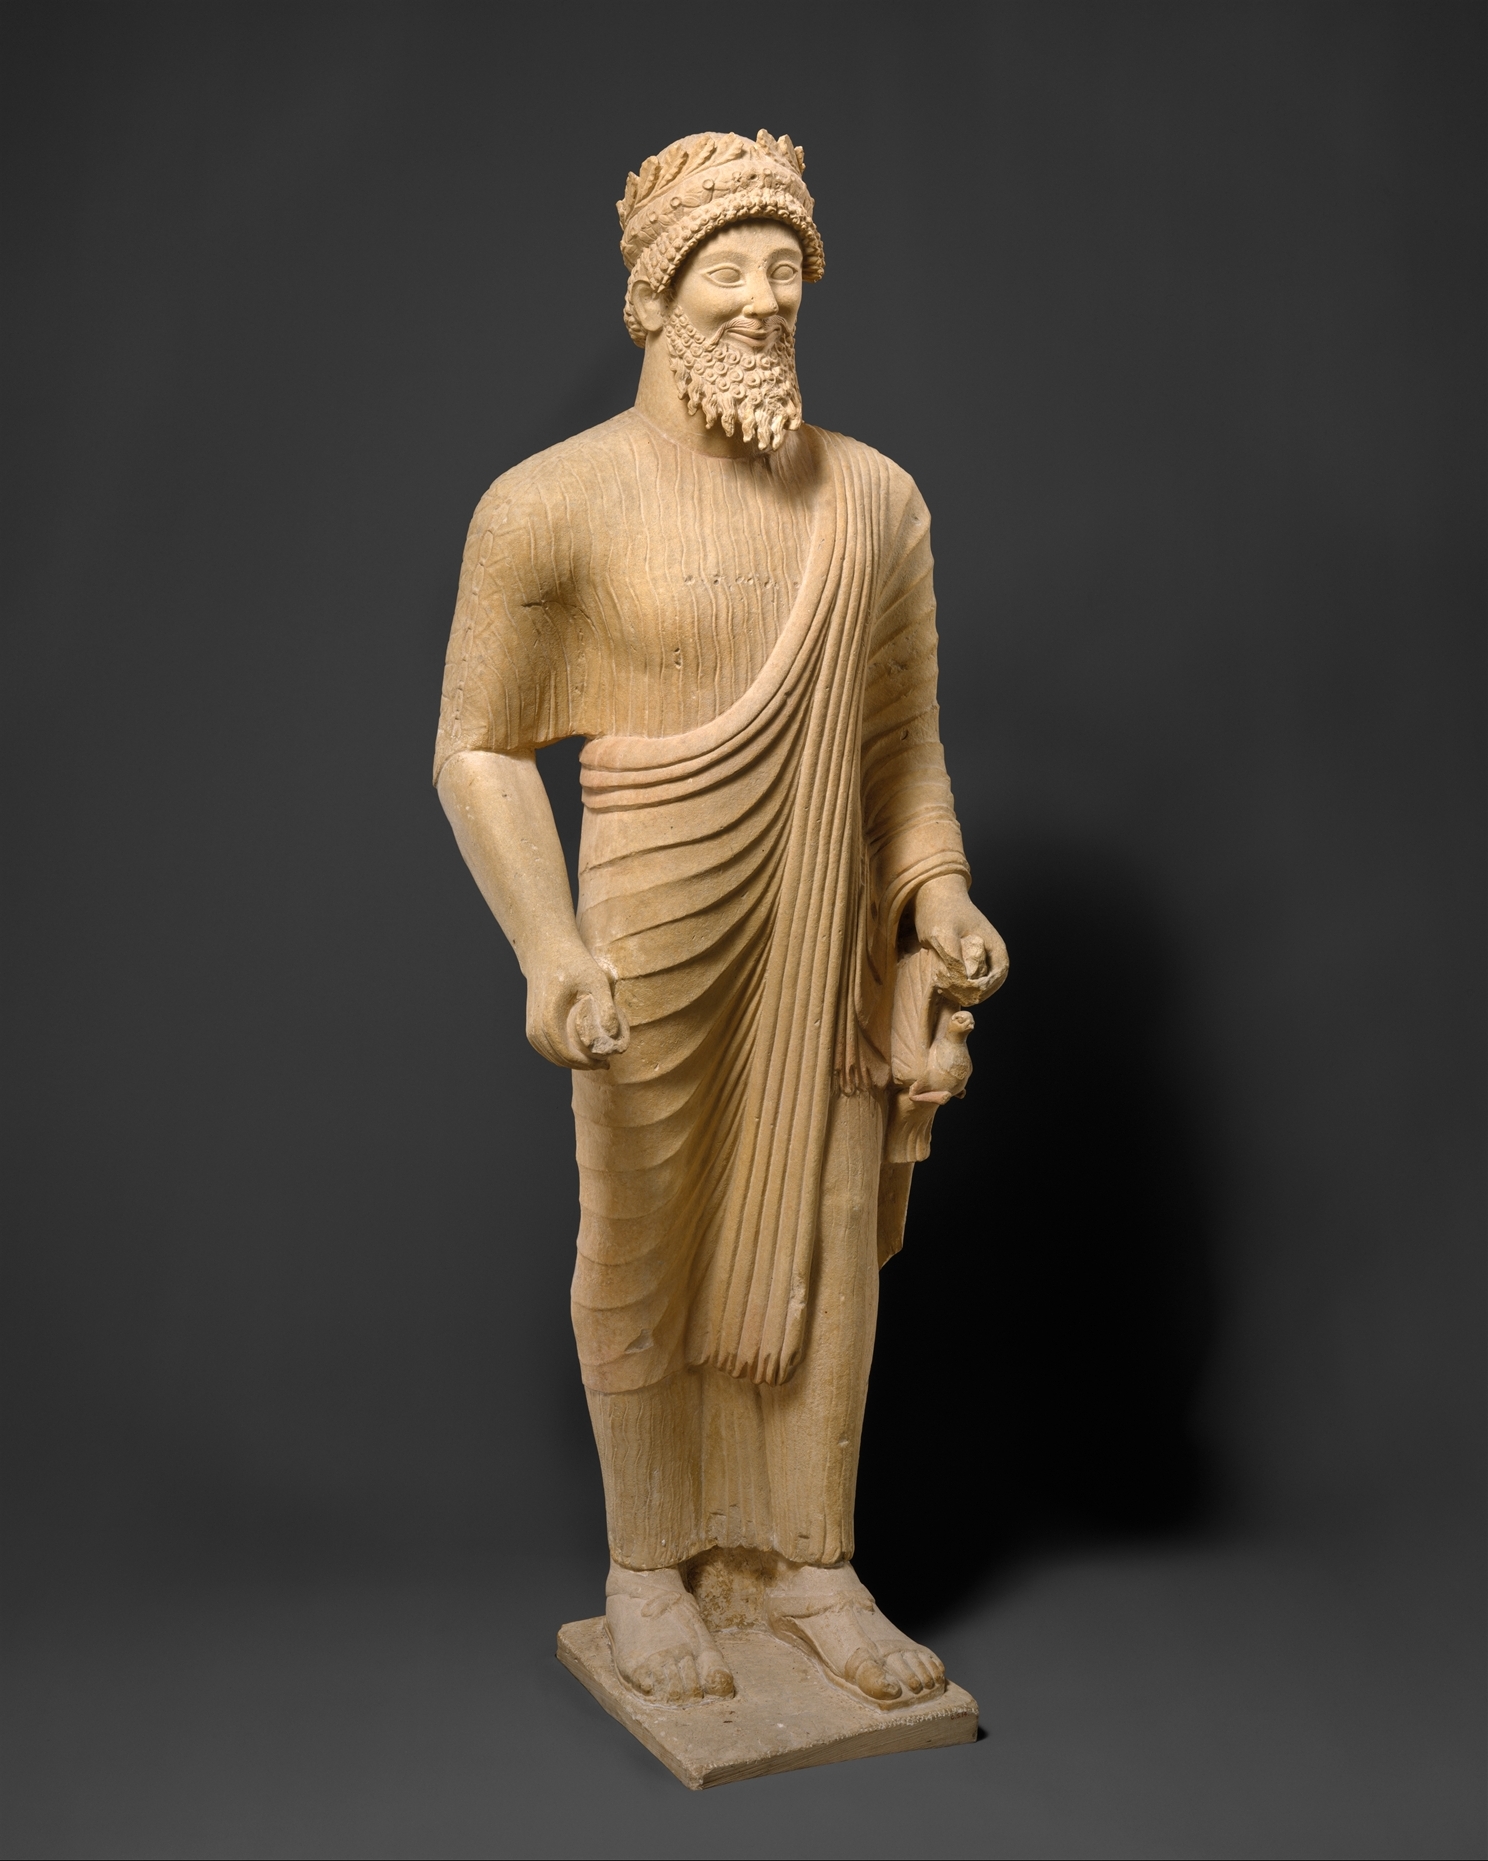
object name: statue of a man, bearded, wearing a wreath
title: Limestone statue of a bearded man with votive offerings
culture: cypriot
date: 475-450 BCE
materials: limestone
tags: men